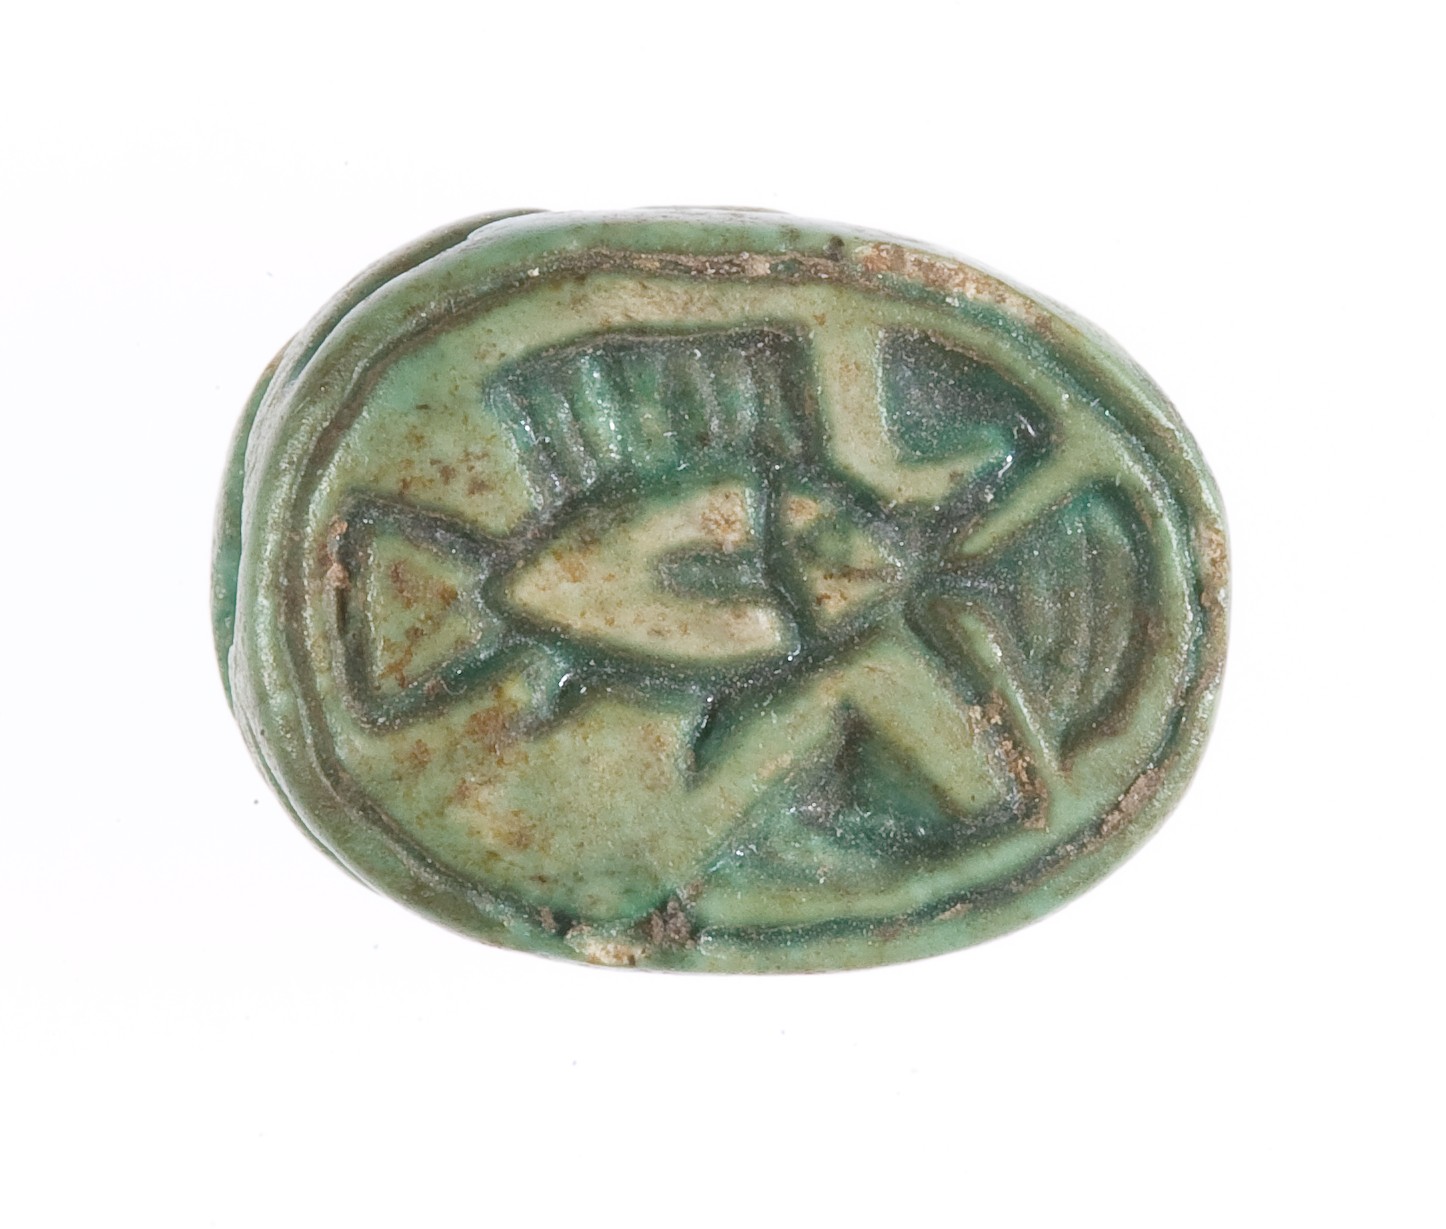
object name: scarab, bolti fish, lotus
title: Scarab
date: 1550-1458 BCE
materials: stone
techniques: glazing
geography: egypt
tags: fish,scarabs